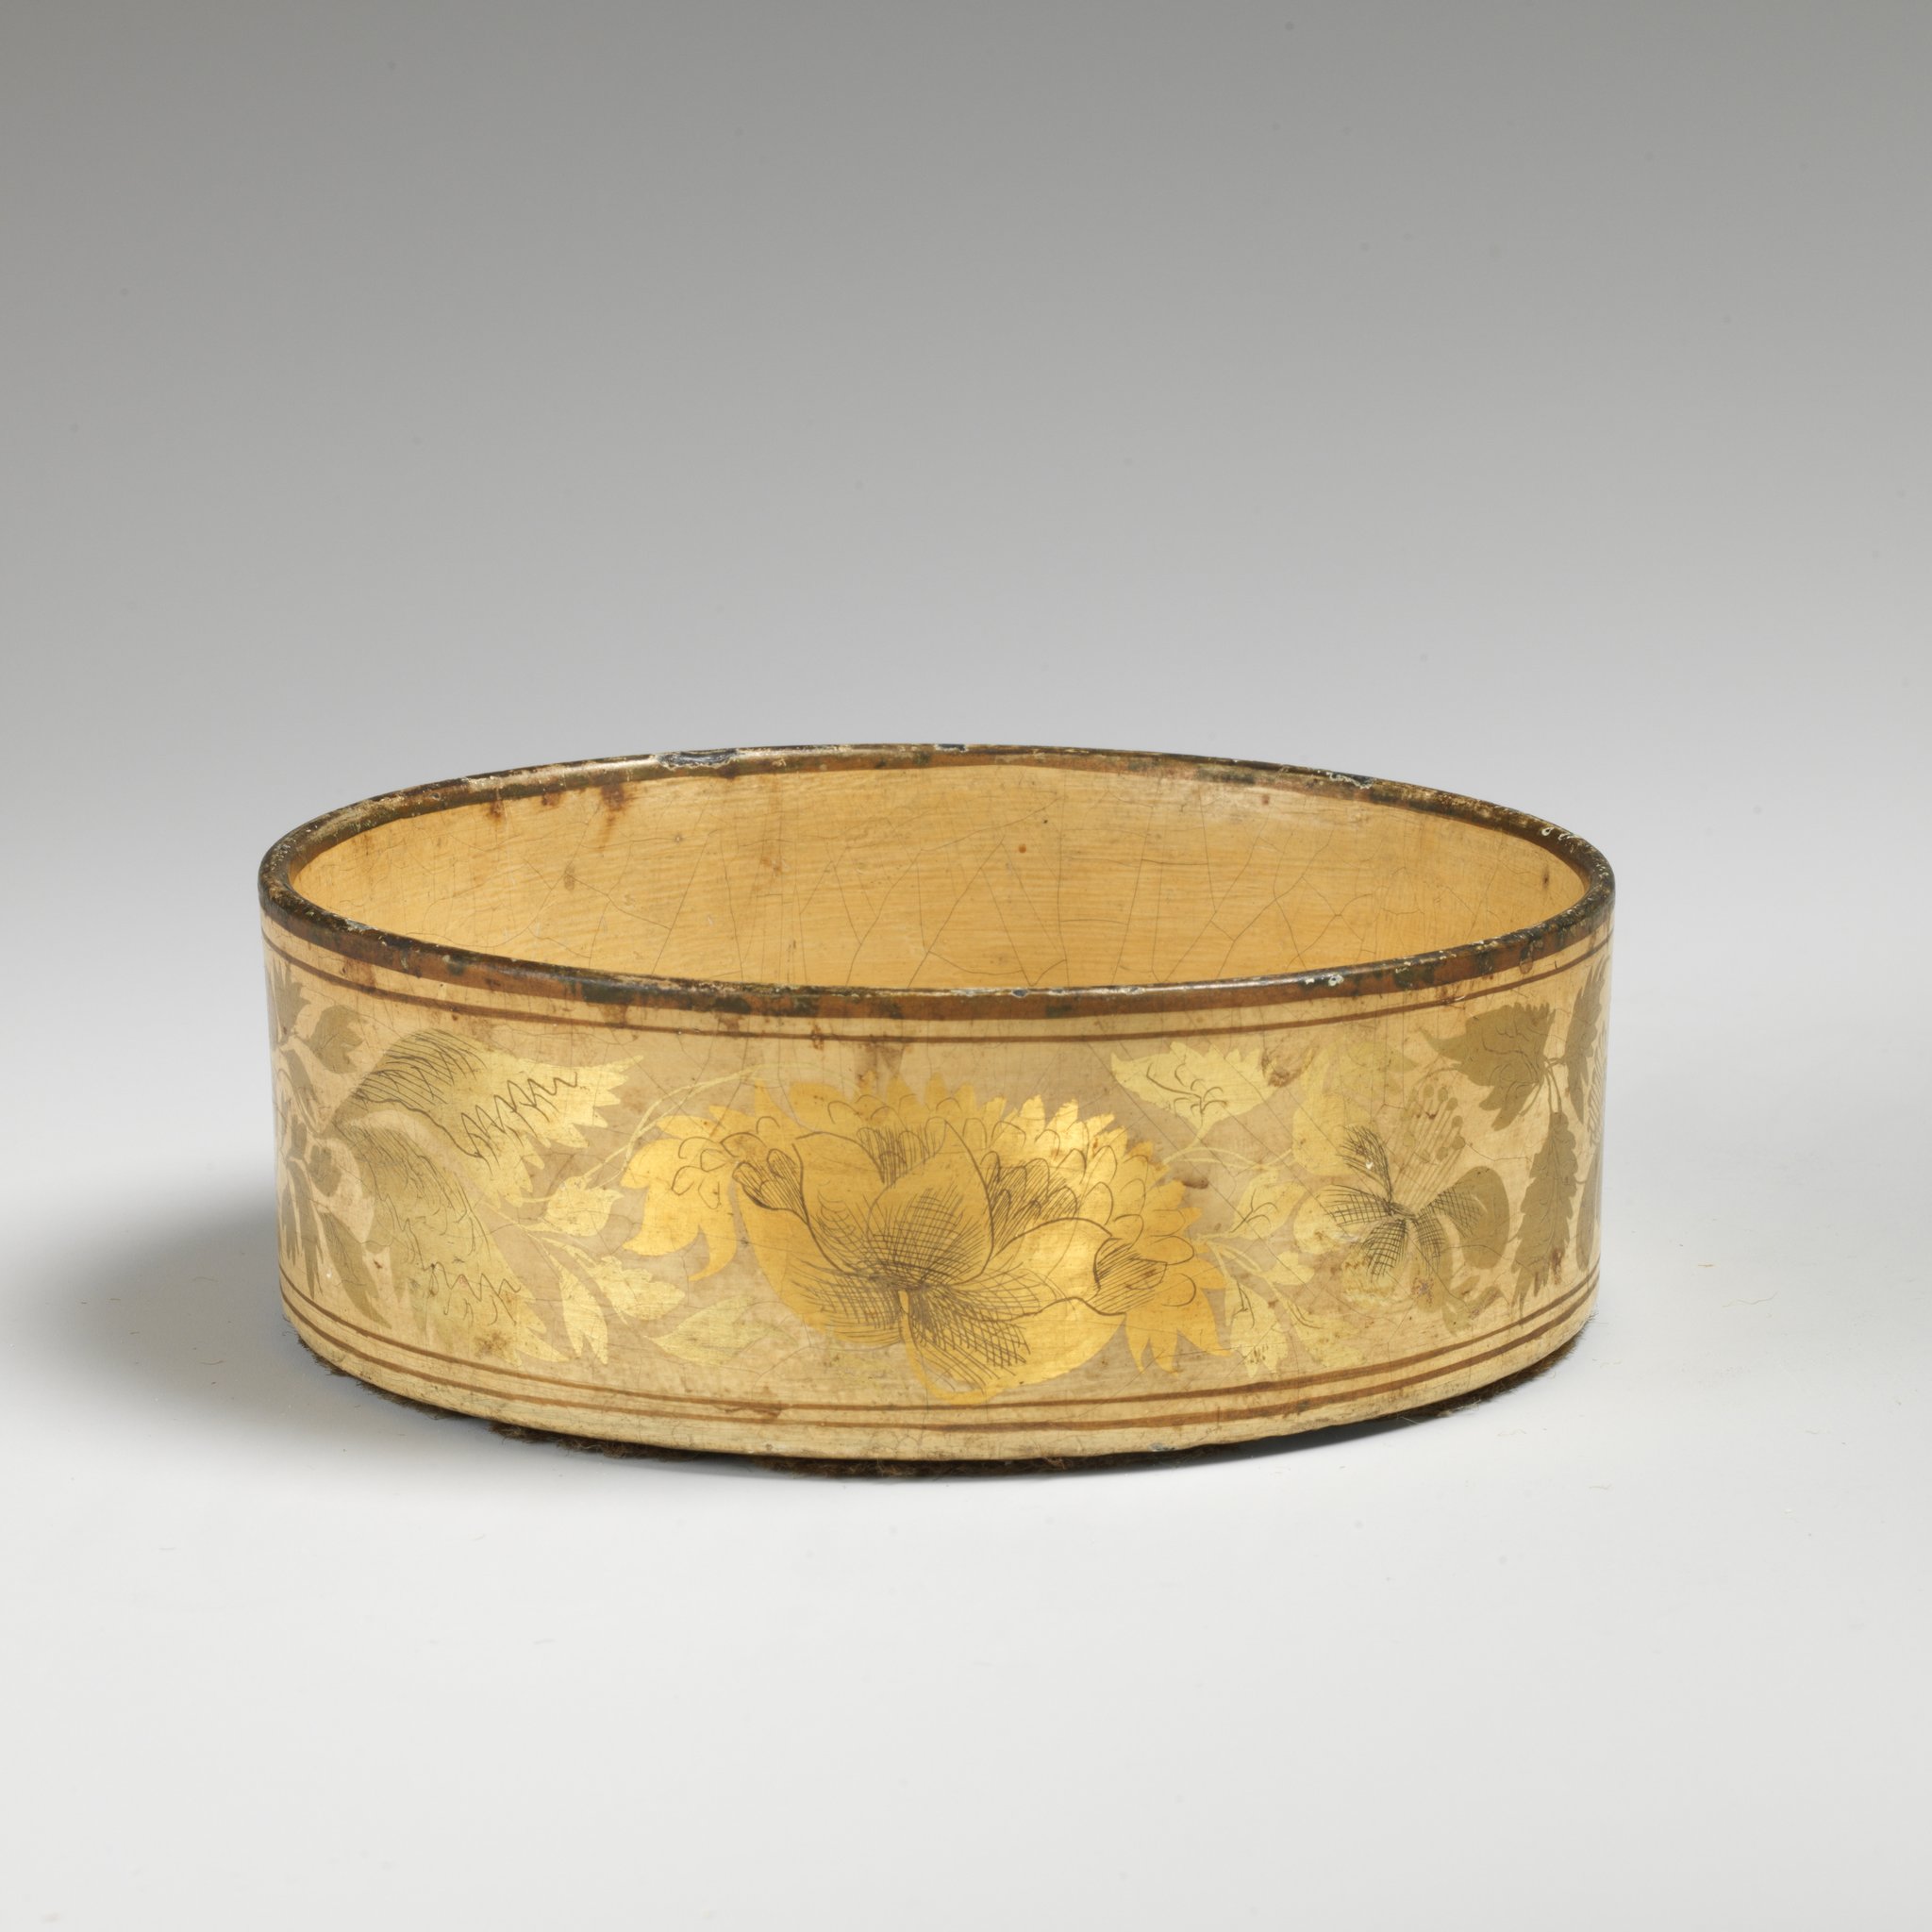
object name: coaster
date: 1701-1900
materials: lacquer